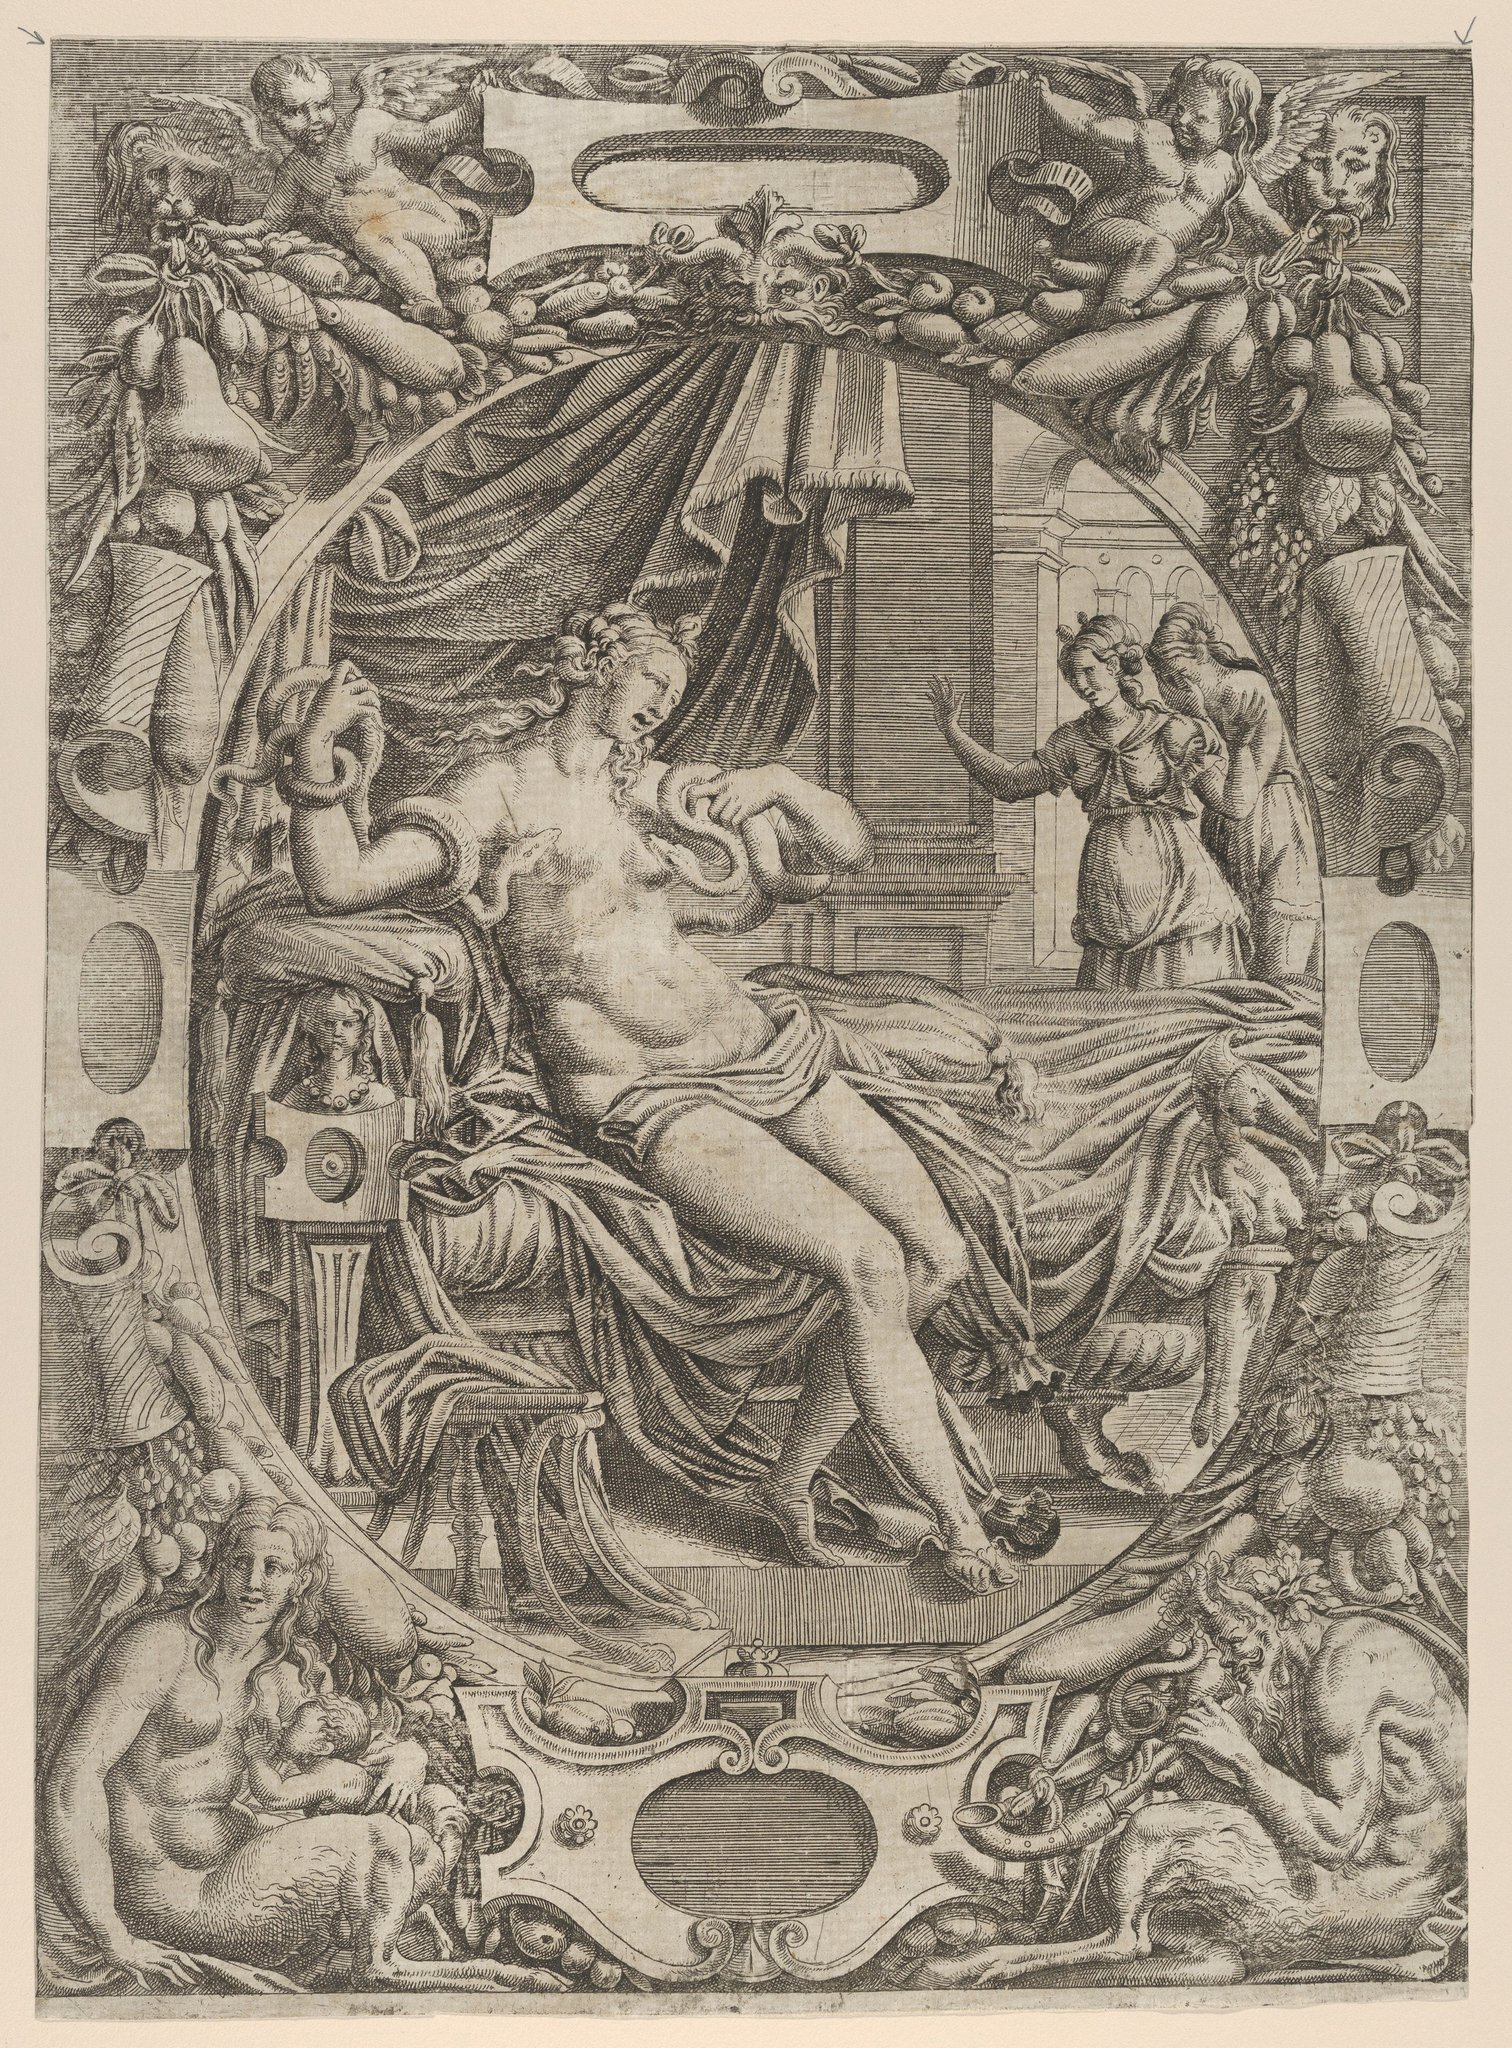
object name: print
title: Cleopatra Bitten By an Asp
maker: jean mignon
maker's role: artist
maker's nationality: french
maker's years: 1535-1555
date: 1535-1555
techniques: etching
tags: cleopatra,women,female nudes,snakes